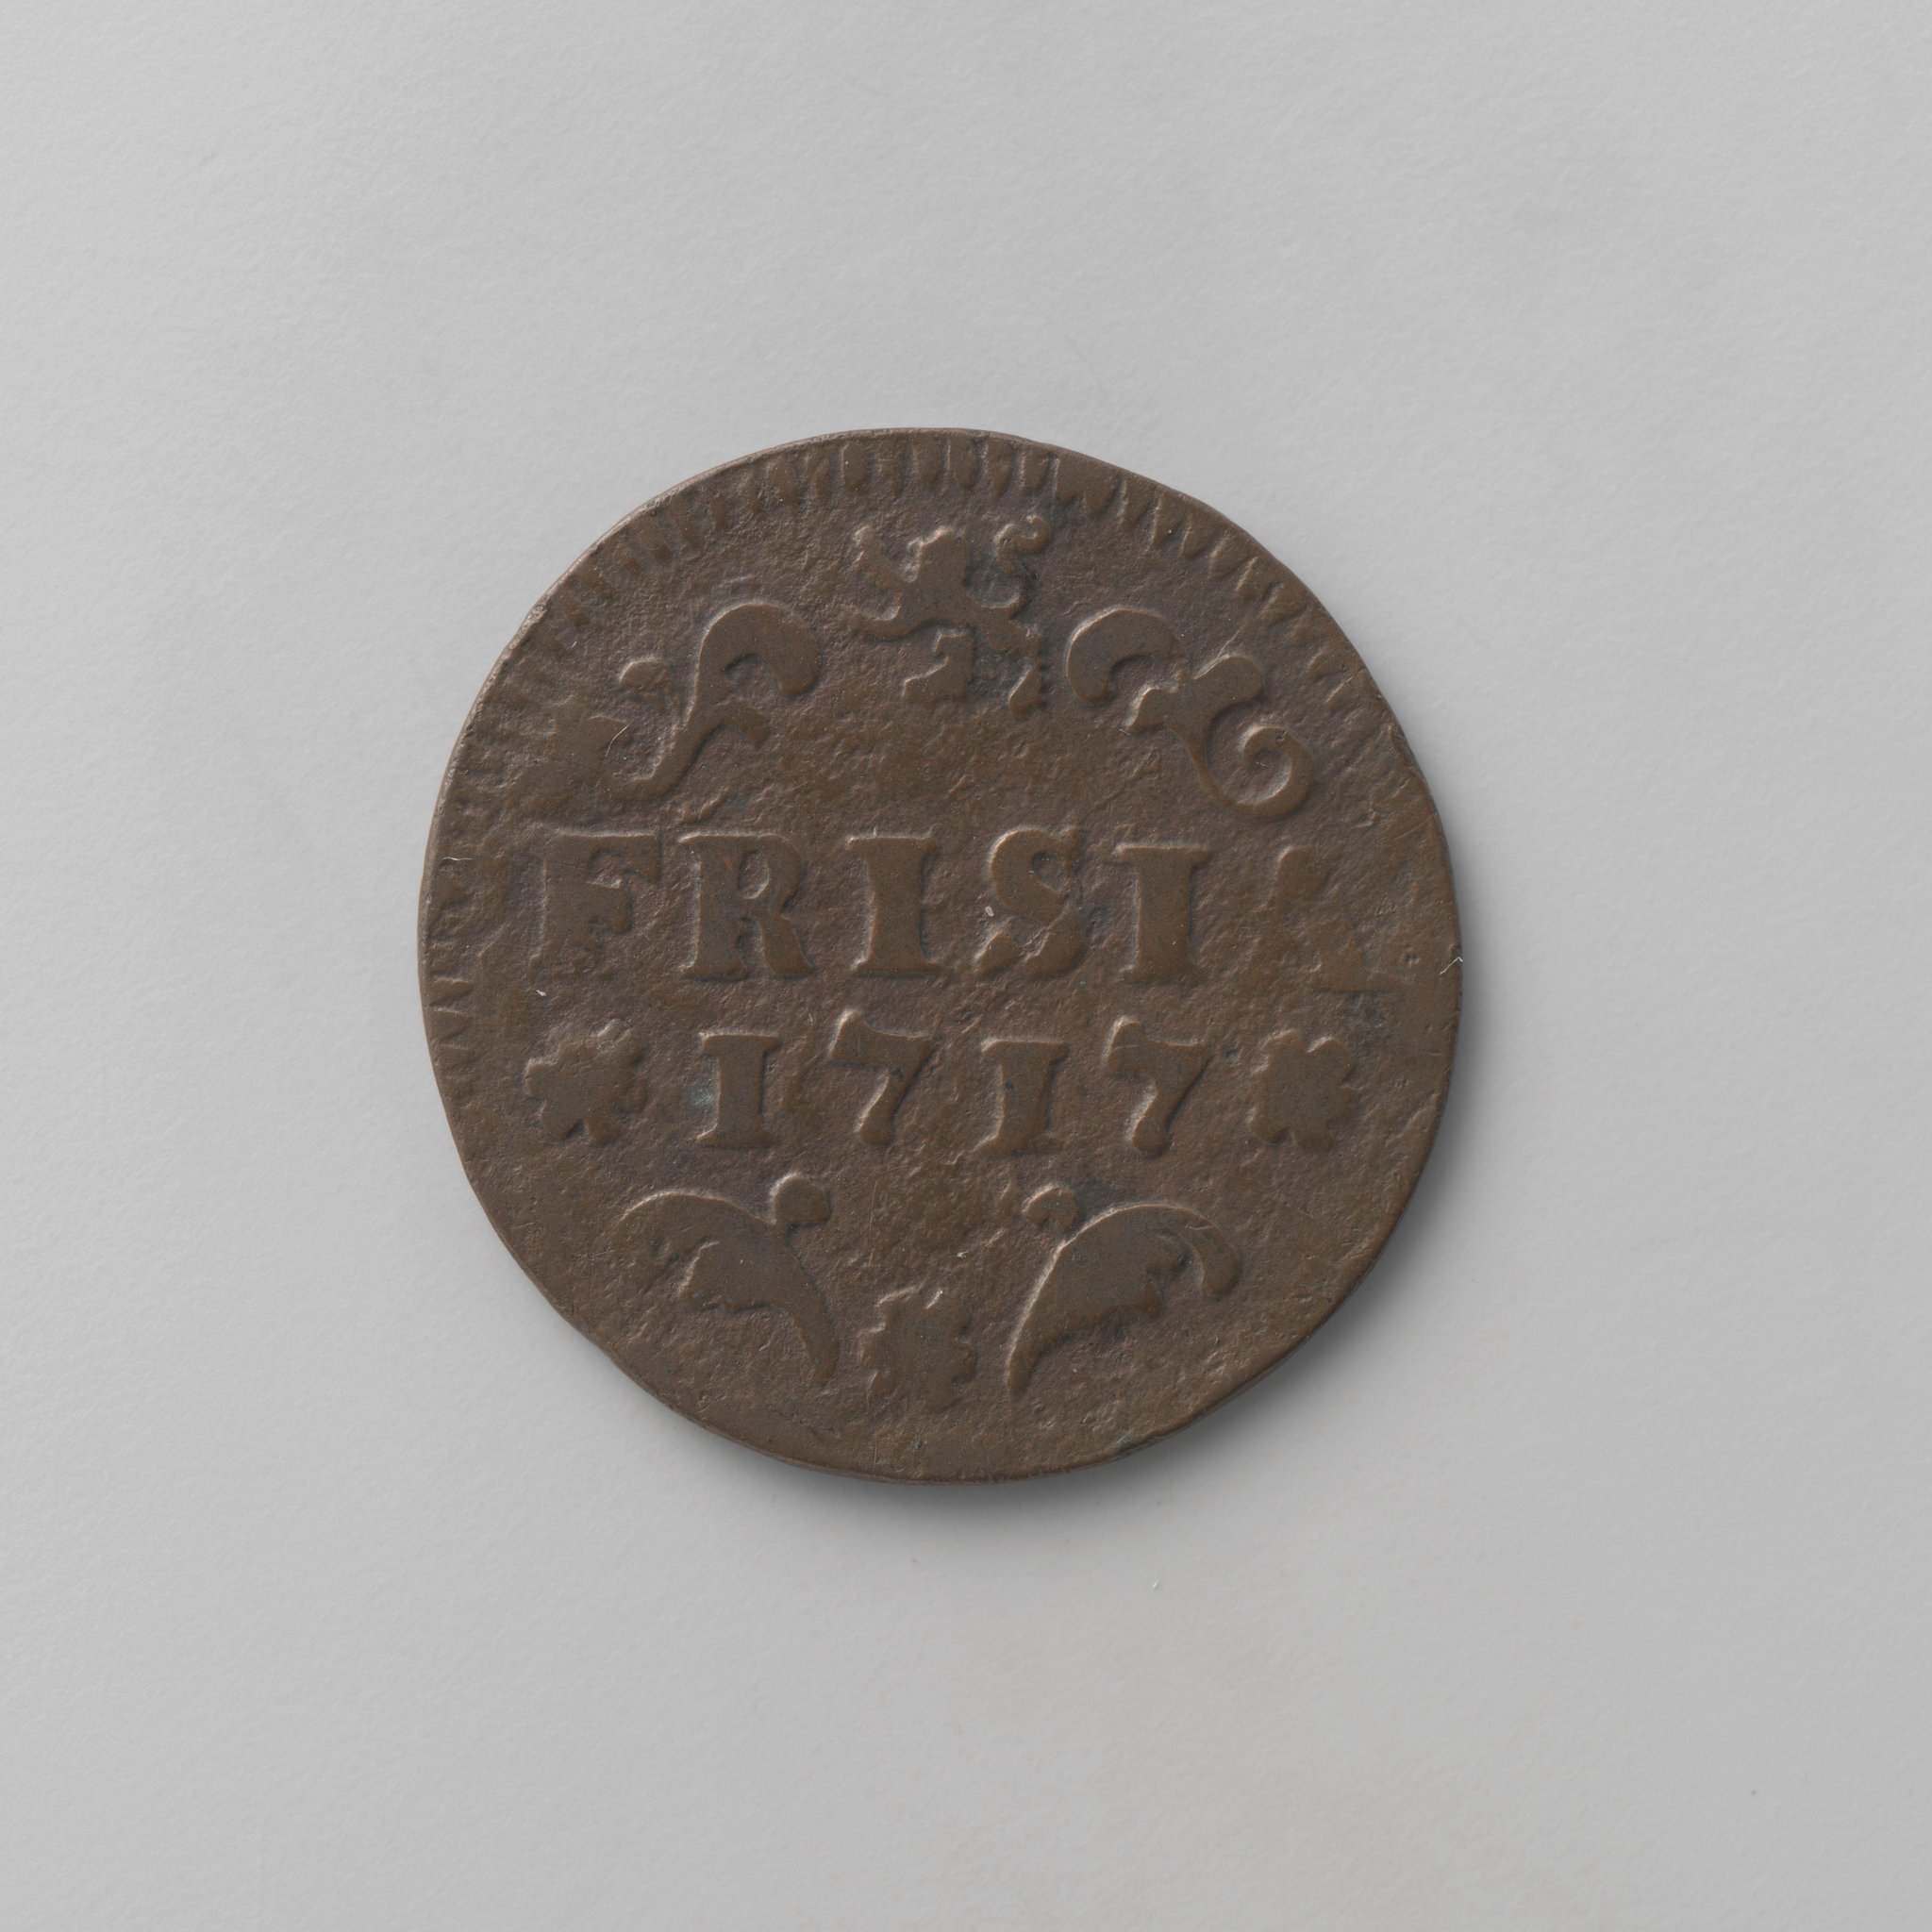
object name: coin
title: Duit van Friesland, 1717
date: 1717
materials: copper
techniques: striking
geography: leeuwarden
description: Koperen munt. Voorzijde: gekroond wapenschild van Friesland met naar boven uitwijkende bladversiering. Keerzijde: muntteken tussen guirlandes, daaronder opschrift in een regel, waaronder jaartal. Daaronder rozet tussen twee guirlandes.